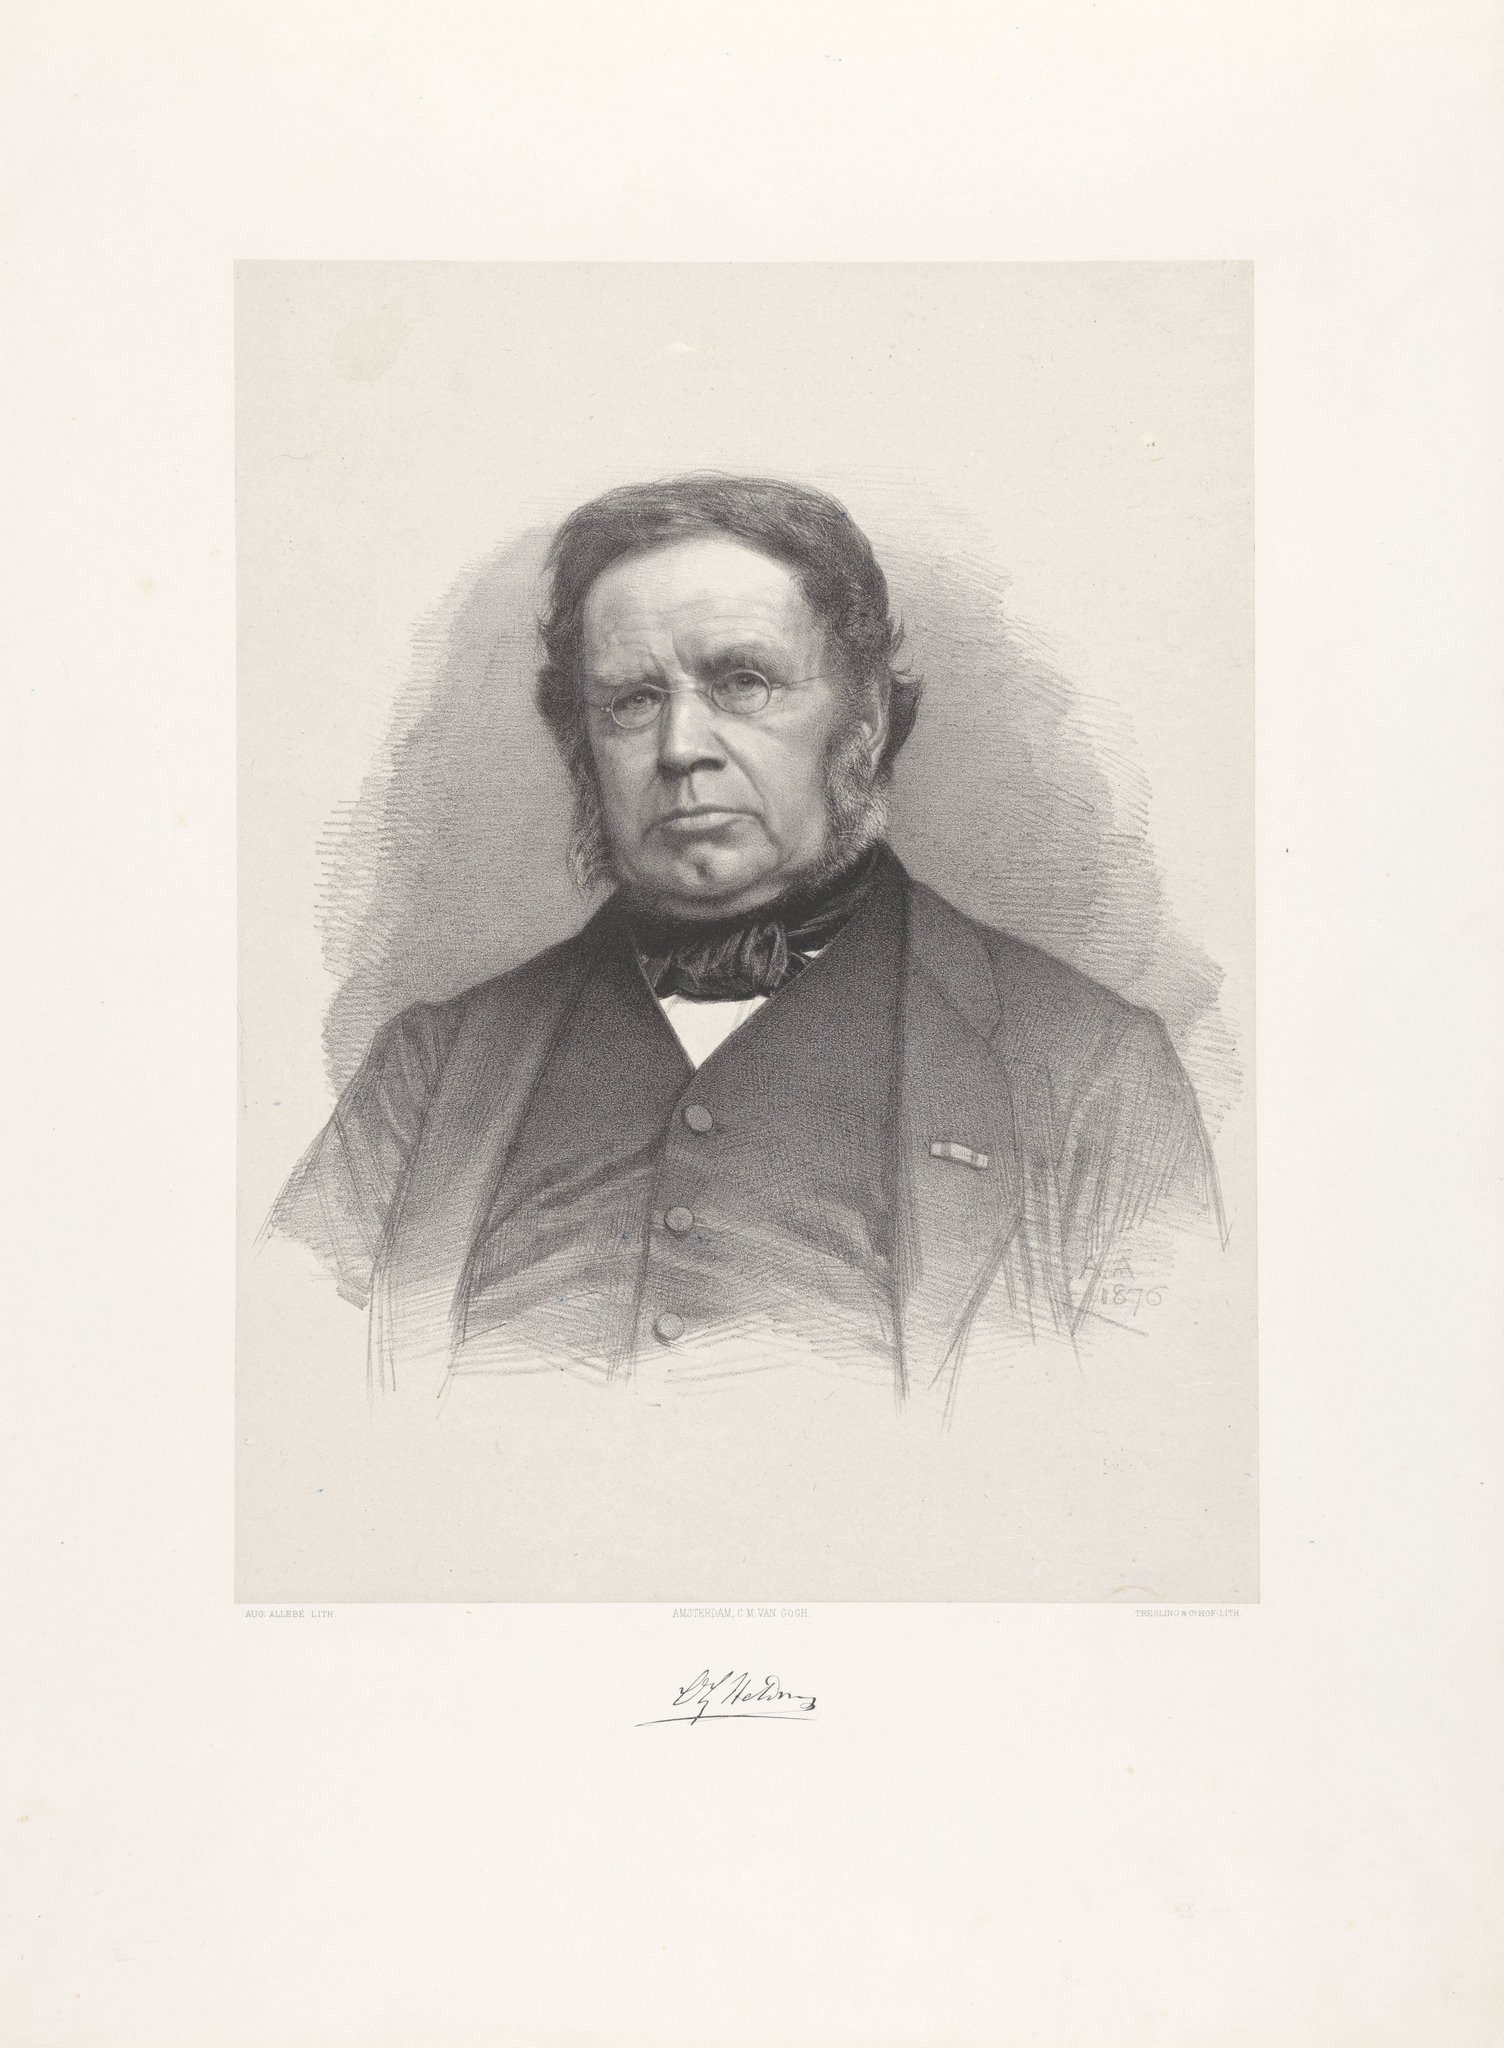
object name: print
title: Portret van dominee Ottho Gerhard Heldring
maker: cornelis marinus van gogh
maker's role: publisher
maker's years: 1824-1908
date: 1876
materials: paper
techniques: lithography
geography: amsterdam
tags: marienbad, historical persons, functionaries and dignitaries ~ protestant churches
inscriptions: date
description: Onder het portret signatuur van de geportretteerde.